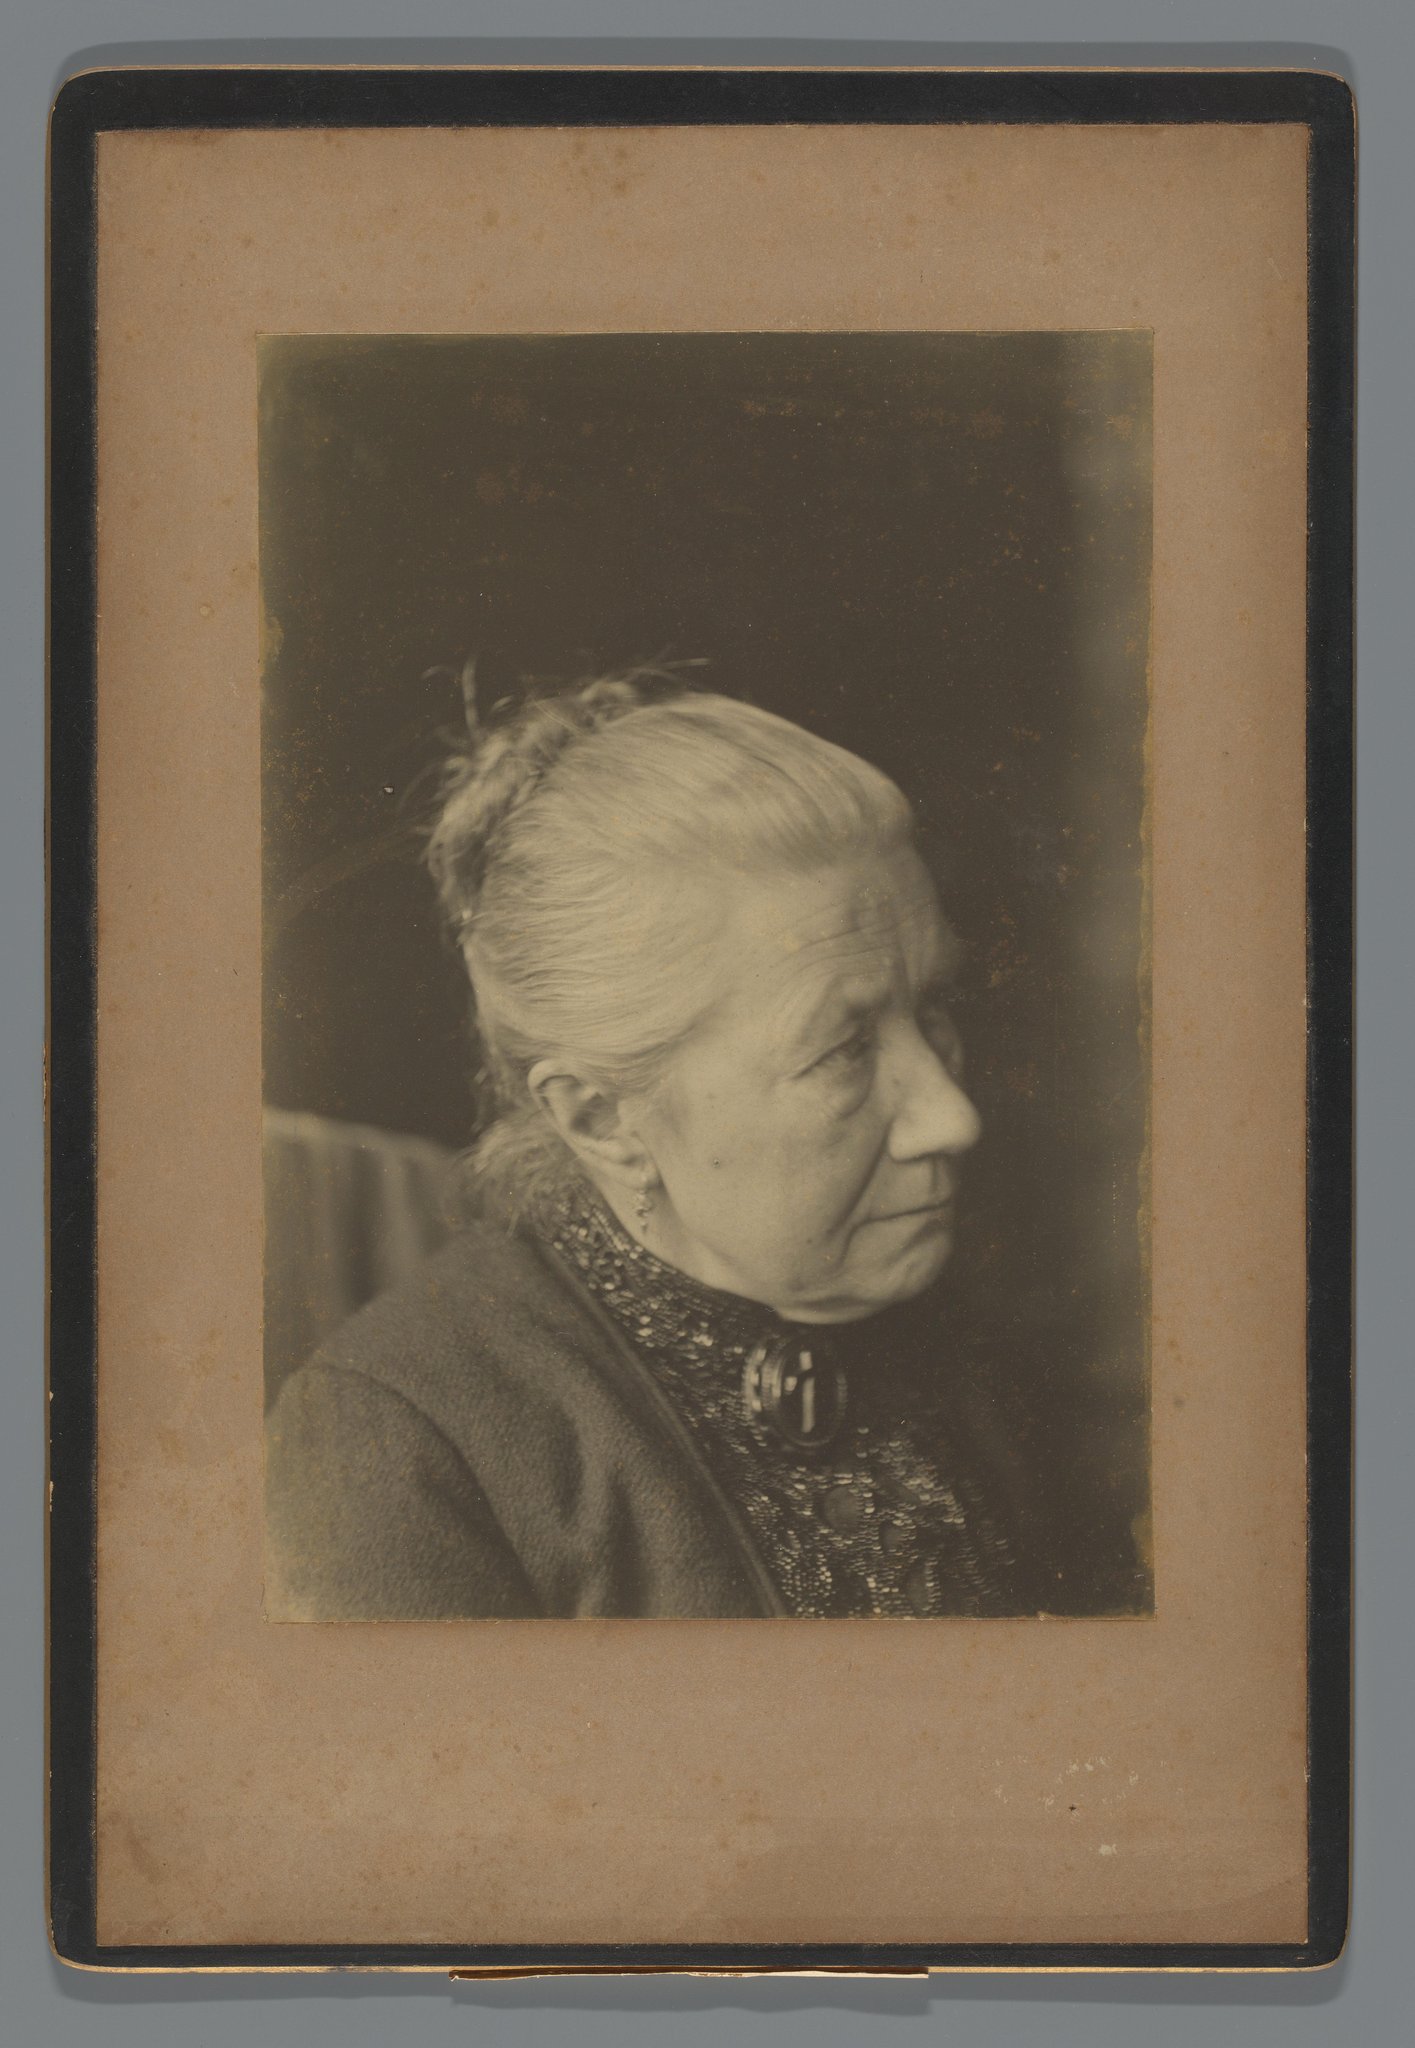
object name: photograph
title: Portret van Johanna Josephina Diepenbrock-Kuytenbrouwer, de moeder van Alphons Diepenbrock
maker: joseph jessurun de mesquita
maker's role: fotograaf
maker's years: 1865-1890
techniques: gelatin silver print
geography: amsterdam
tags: alphons diepenbrock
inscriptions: label: ‘Joseph Jessurun de Mesquita’